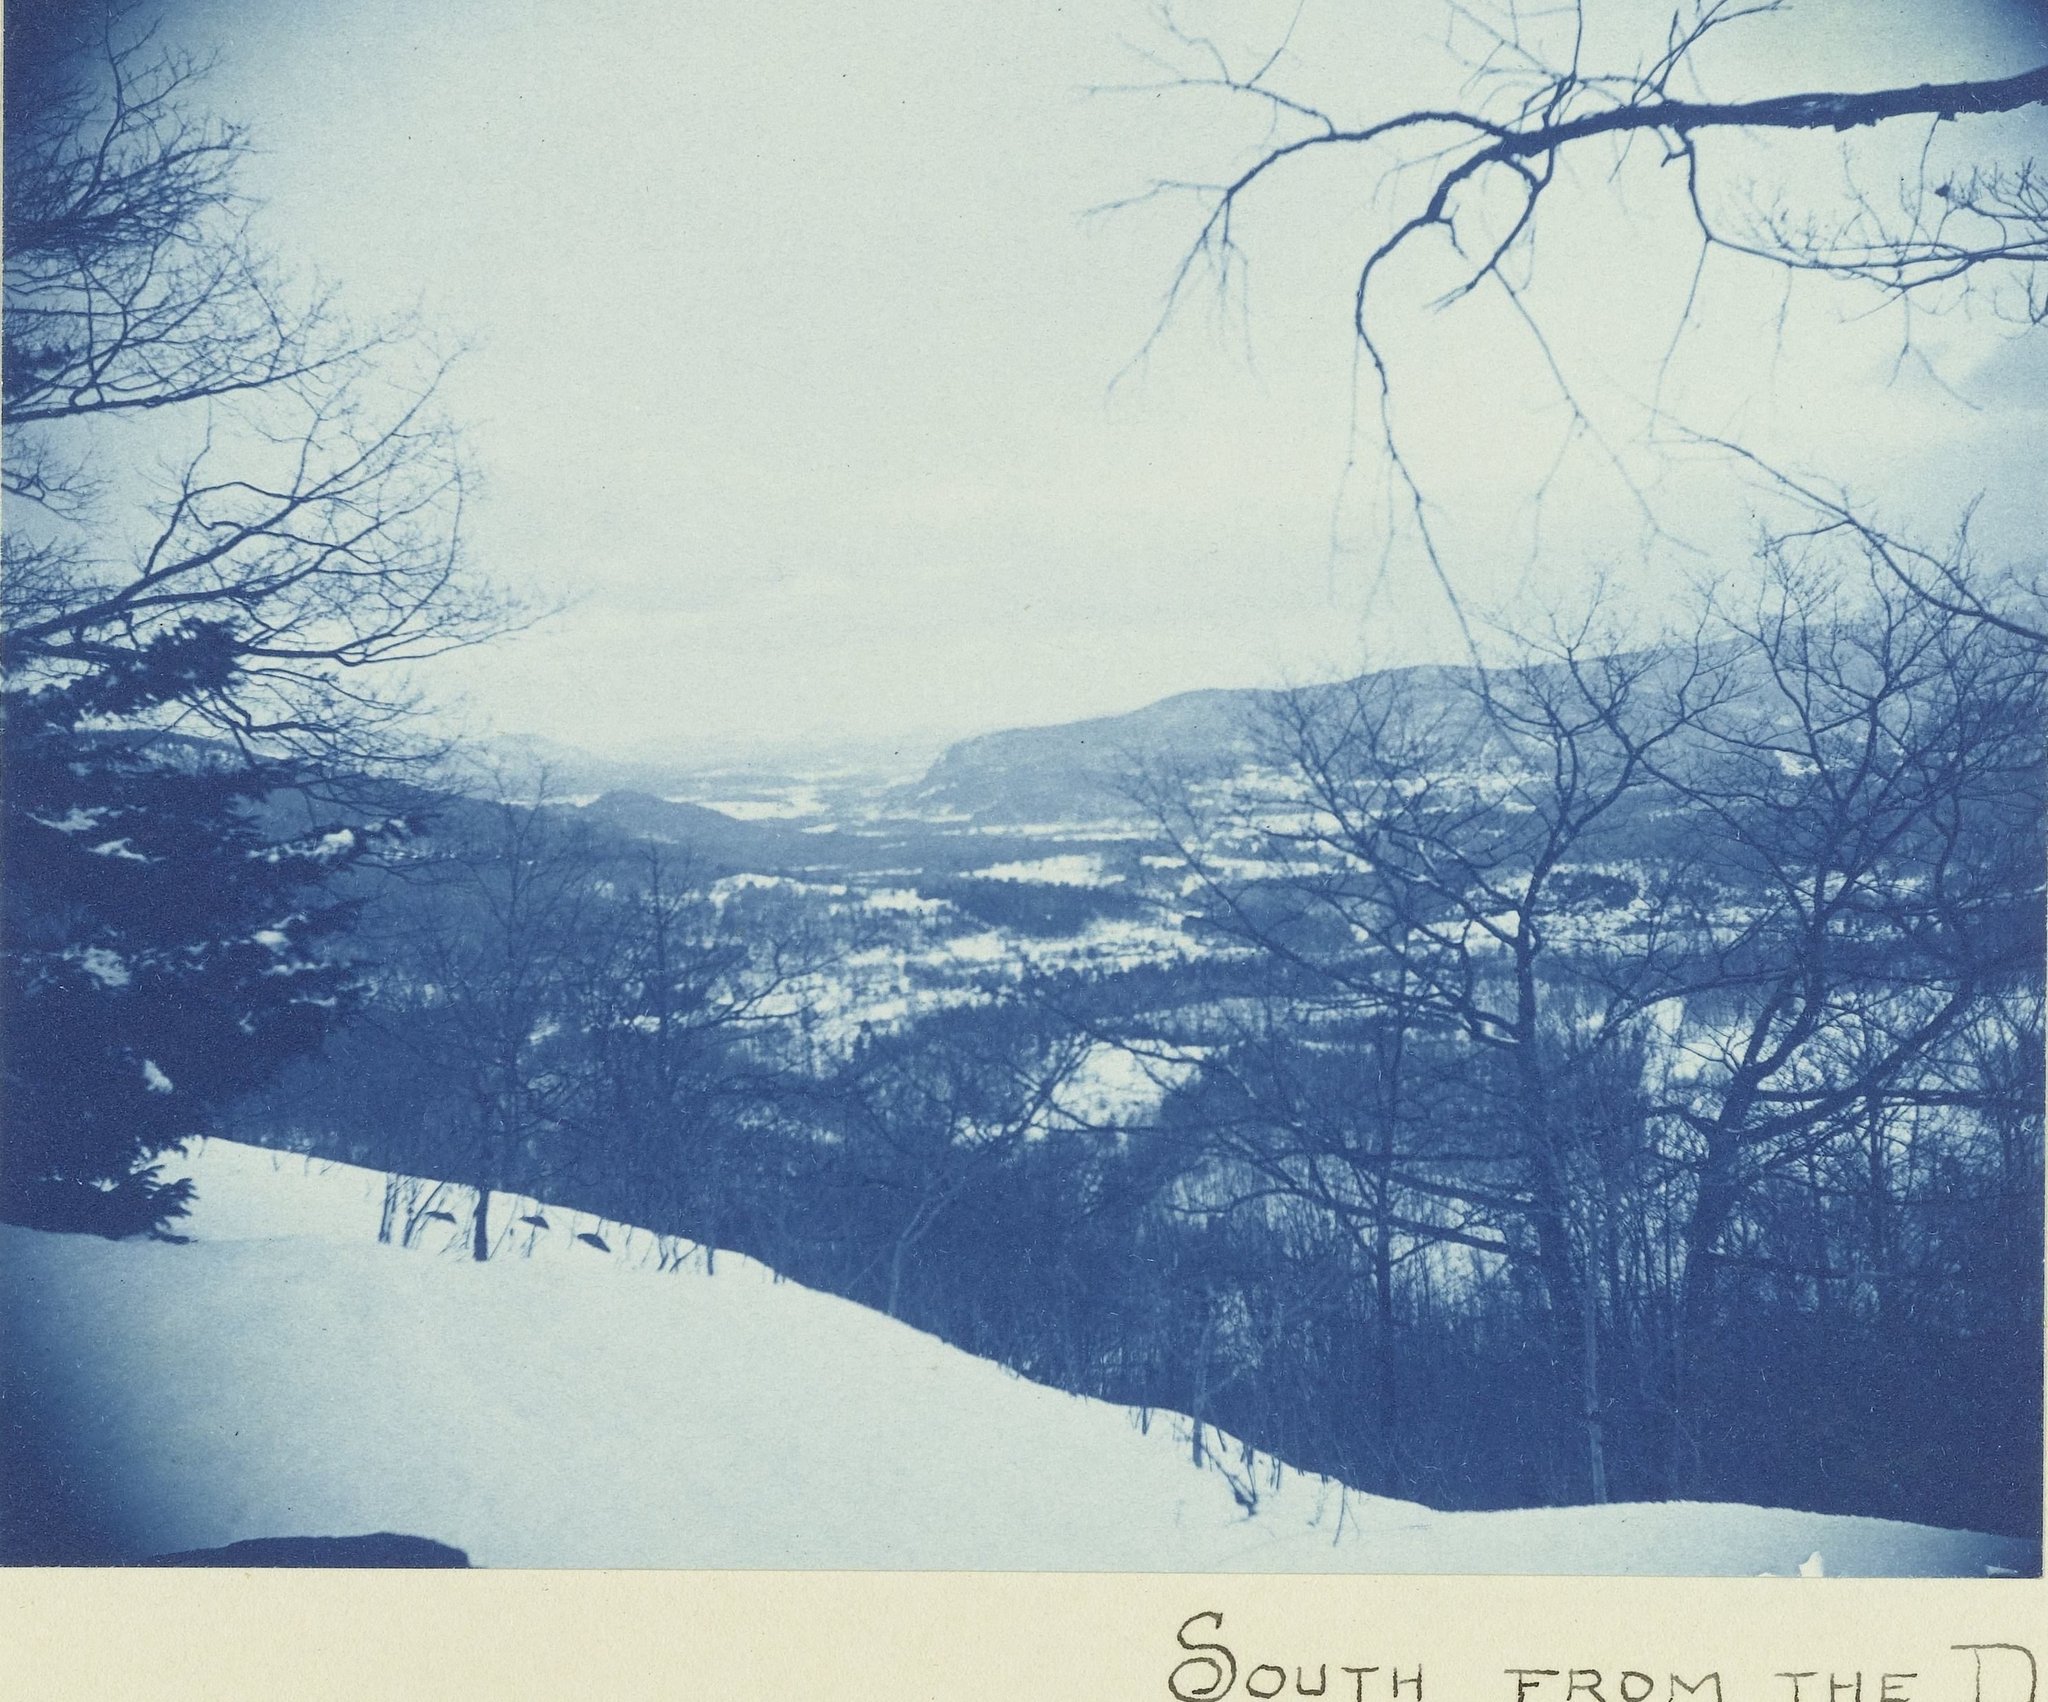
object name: photograph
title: Landschap in de sneeuw, ten zuiden van the Duck's Head, North Conway en The Ledges, NH, Verenigde Staten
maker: charlotte m. endicott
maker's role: fotograaf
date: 1899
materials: photographic support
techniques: cyanotype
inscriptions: title: ‘SOUTH FROM THE DUCK'S HEAD. / NORTH CONWAY & THE LEDGES. / FEB. 19. 1899’